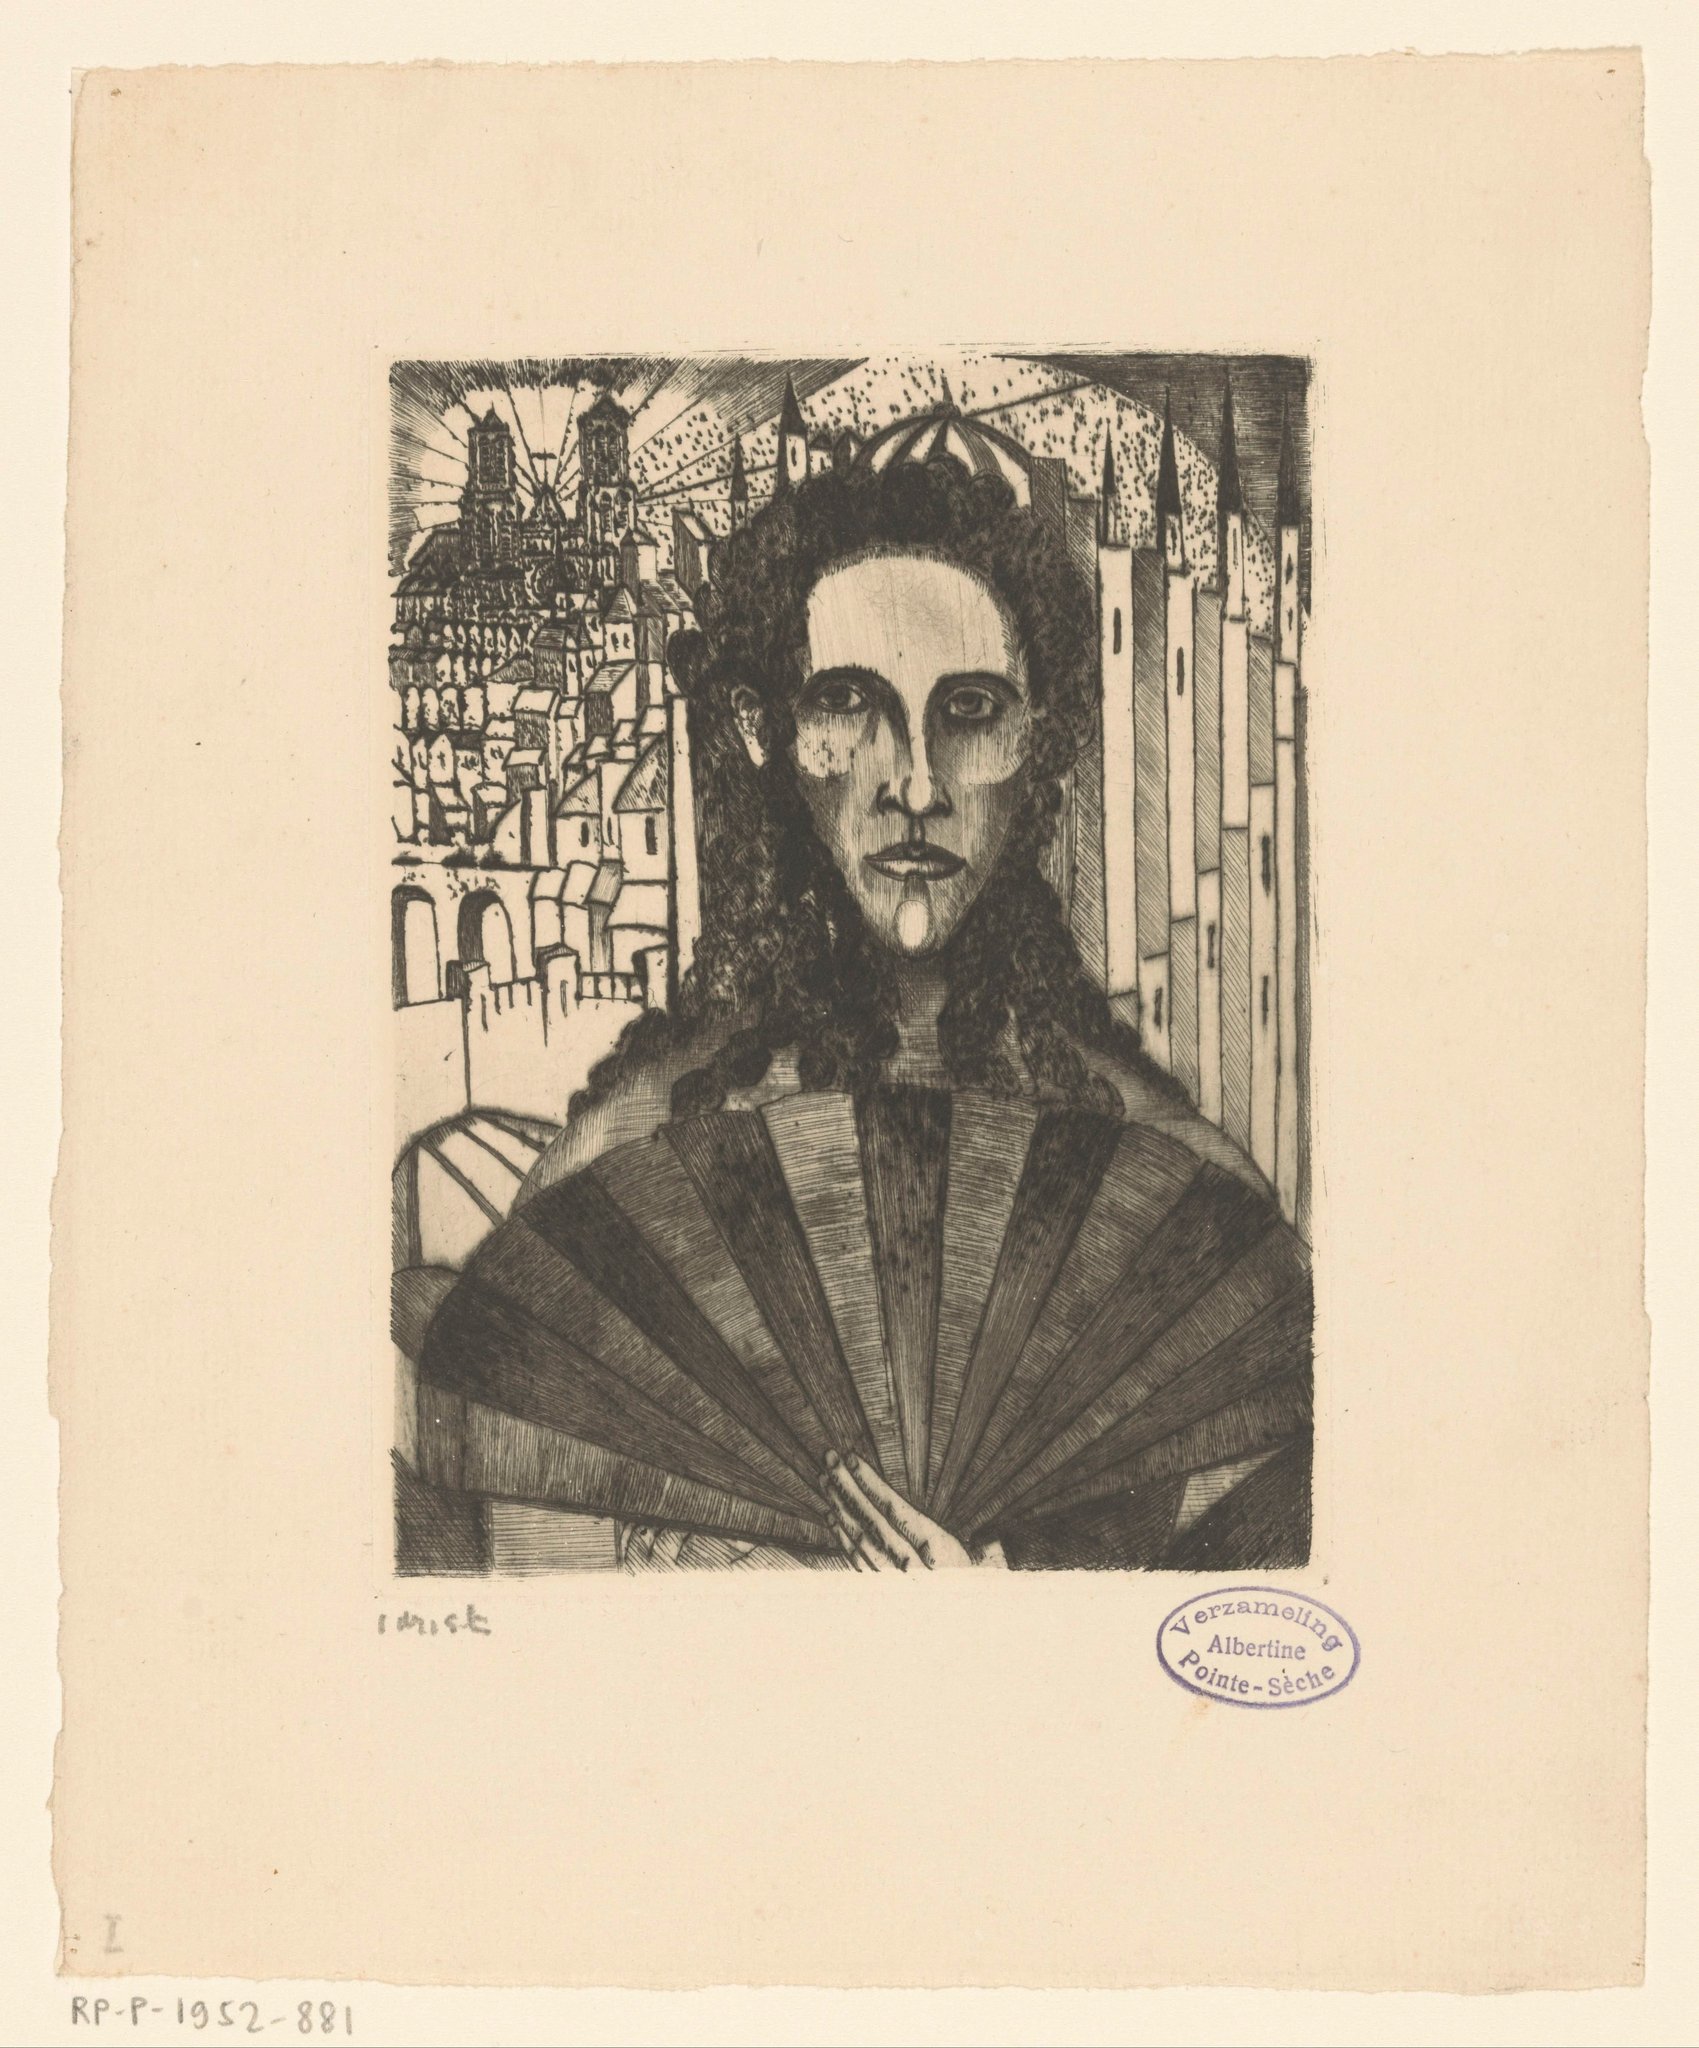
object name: print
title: Vrouw met een waaier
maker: lodewijk schelfhout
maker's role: draughtsman, print maker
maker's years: 1881-1943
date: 1915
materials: paper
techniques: drypoint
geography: netherlands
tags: city-view, and landscape with man-made constructions, fan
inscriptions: collector's mark: Lugt 2228, collector's mark: Lugt 2760, collector's mark: Lugt 5i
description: Achter haar een nederzetting met een kerk.